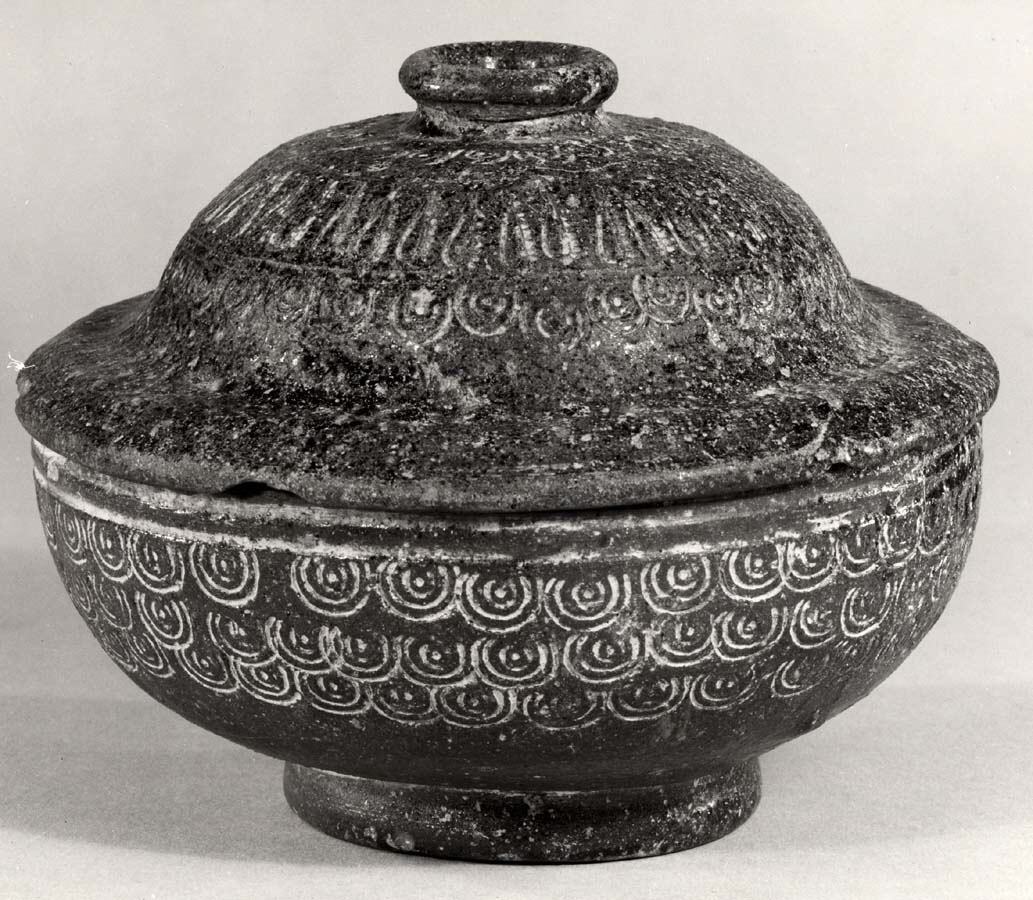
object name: bowl with cover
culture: korean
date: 57 BCE-688 CE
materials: pottery